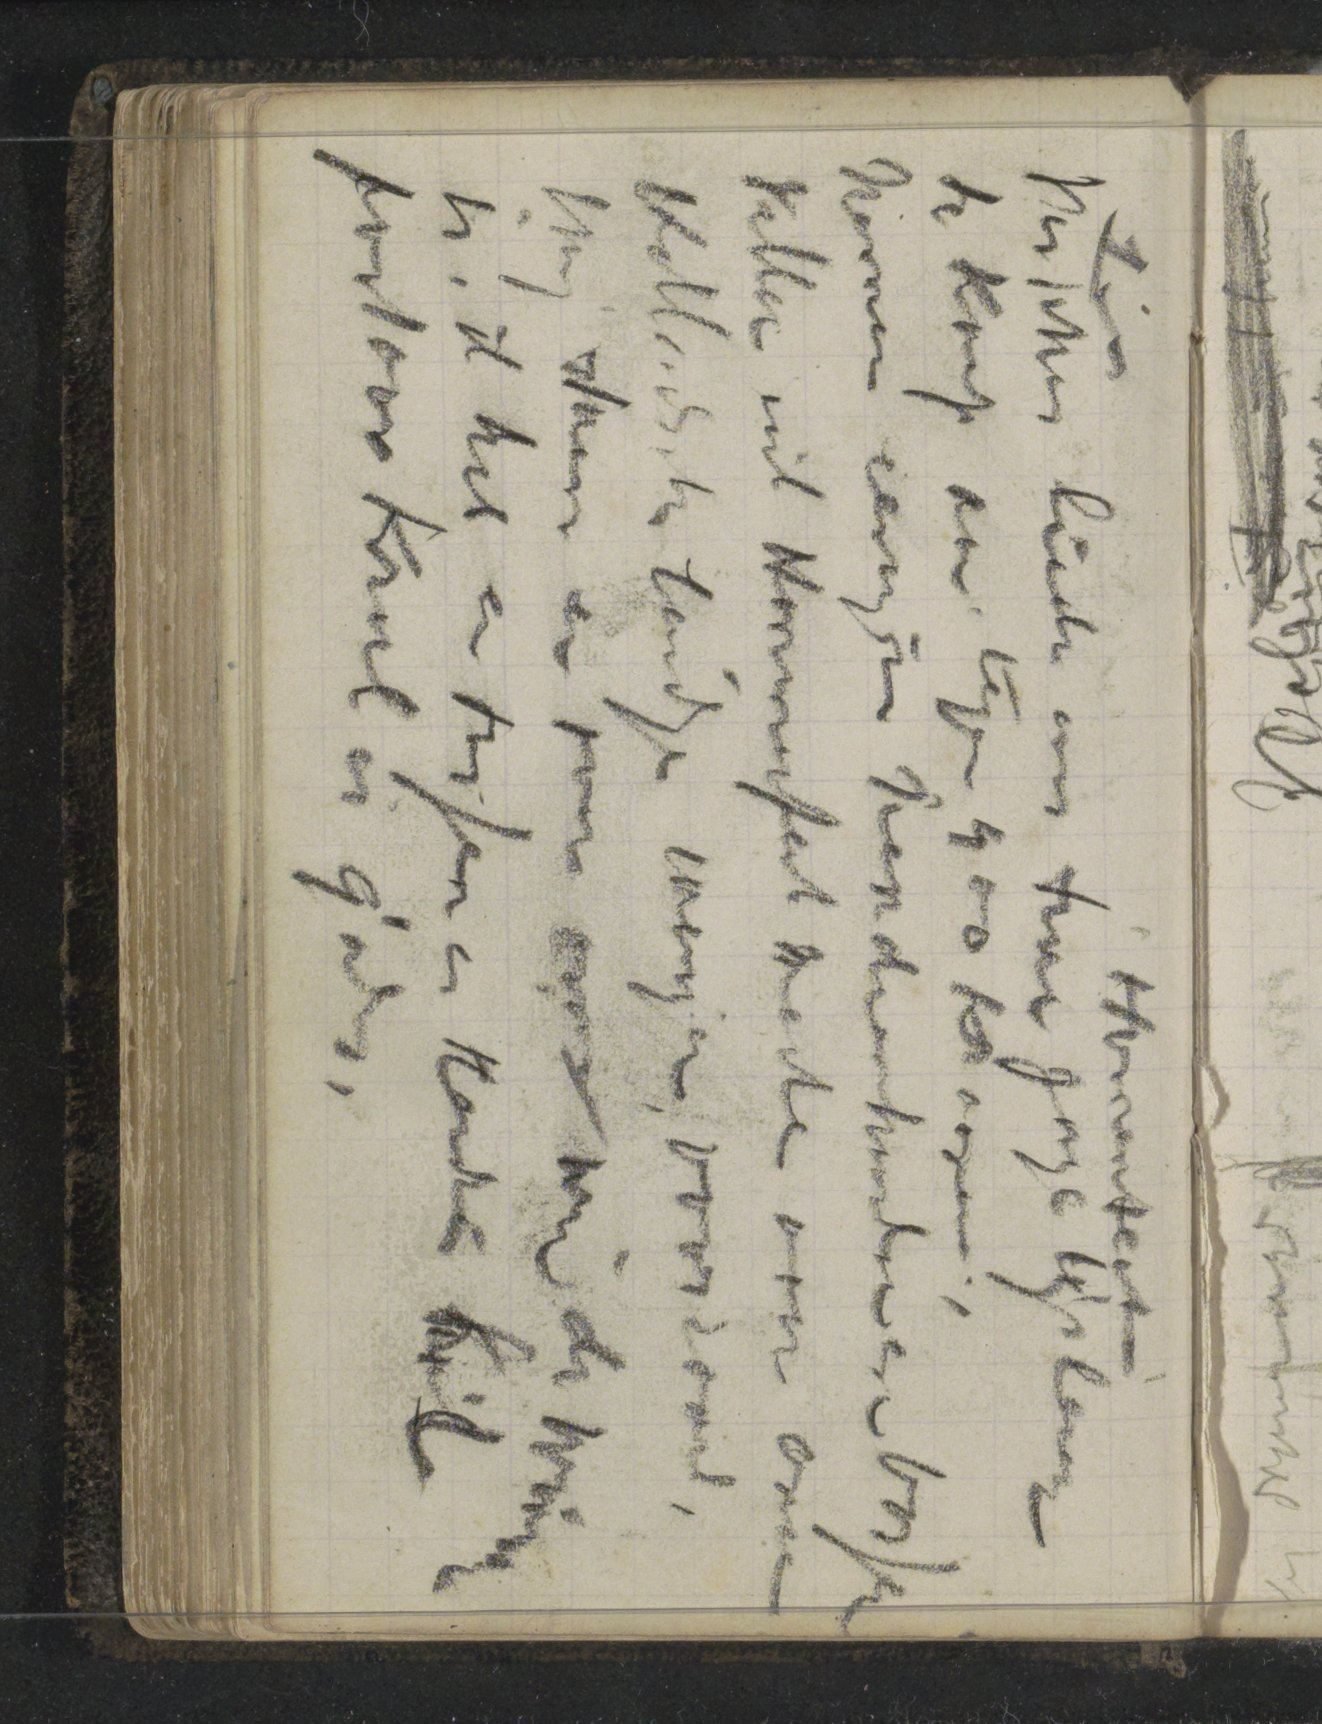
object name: sketchbook leaf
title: Reisverslag van medio juli 1880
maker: louis apol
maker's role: draughtsman, painter, print maker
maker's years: 1850-1936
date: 1807-1880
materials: chalk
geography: vardø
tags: vardø, nova zembla expedities 1880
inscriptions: annotation: ‘[...]’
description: Blad 64 verso uit een schetsboek met 110 bladen betekend tijdens de expeditie naar Nova Zembla in 1880.